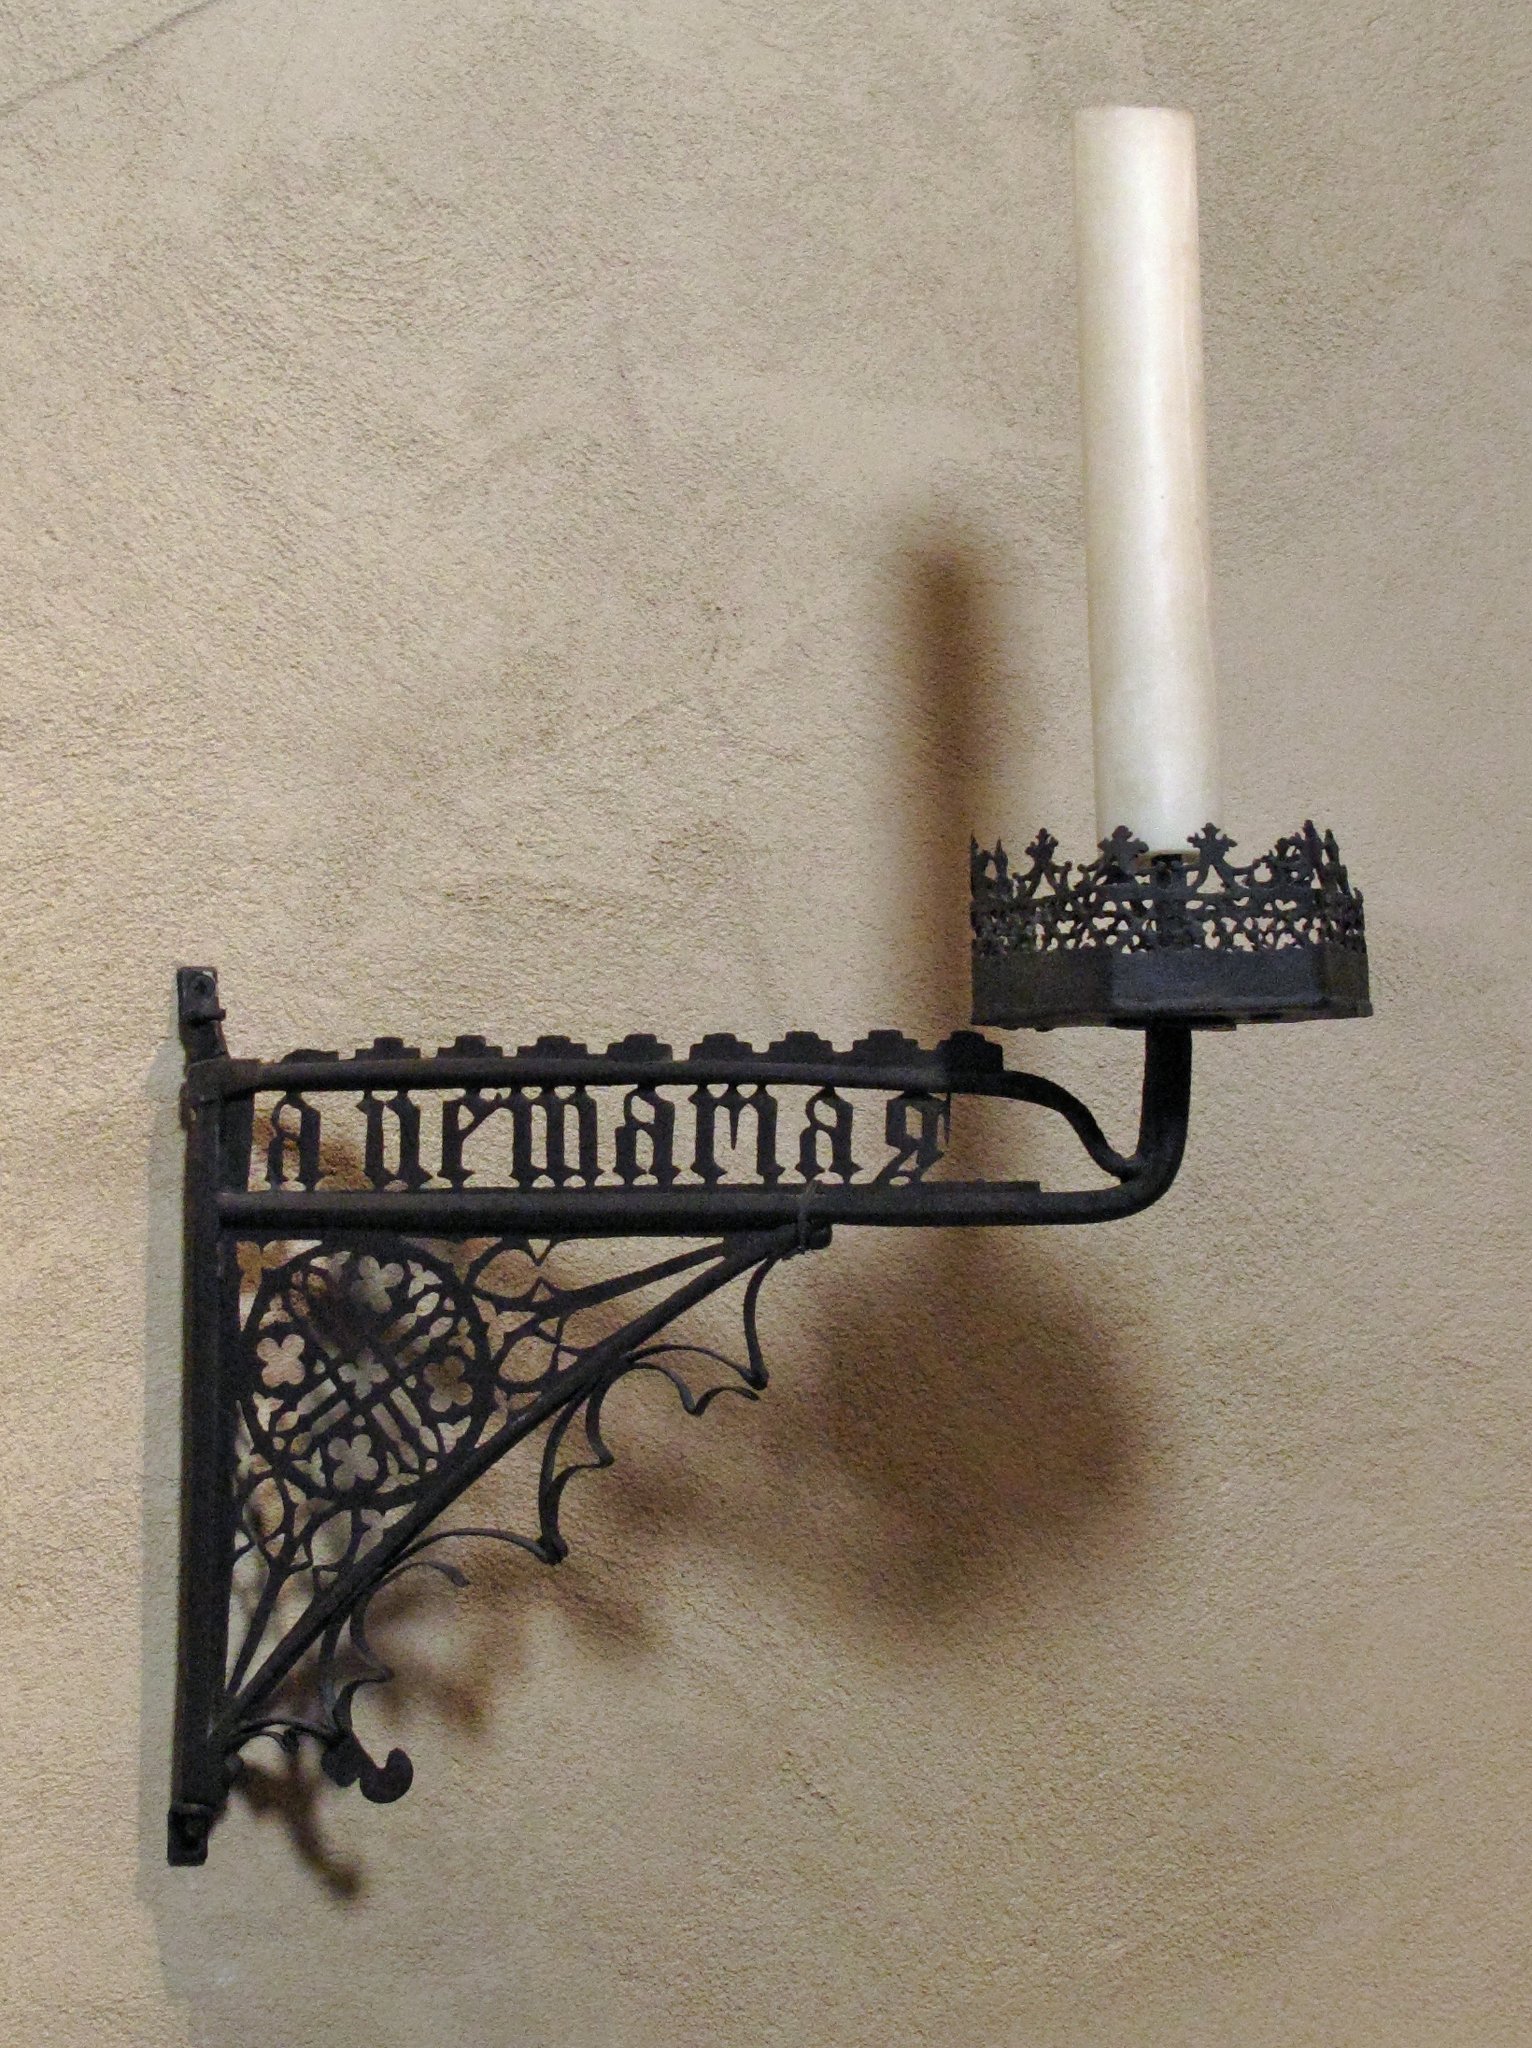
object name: candlestick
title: Candle Bracket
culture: french or south netherlandish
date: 1401-1500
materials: iron